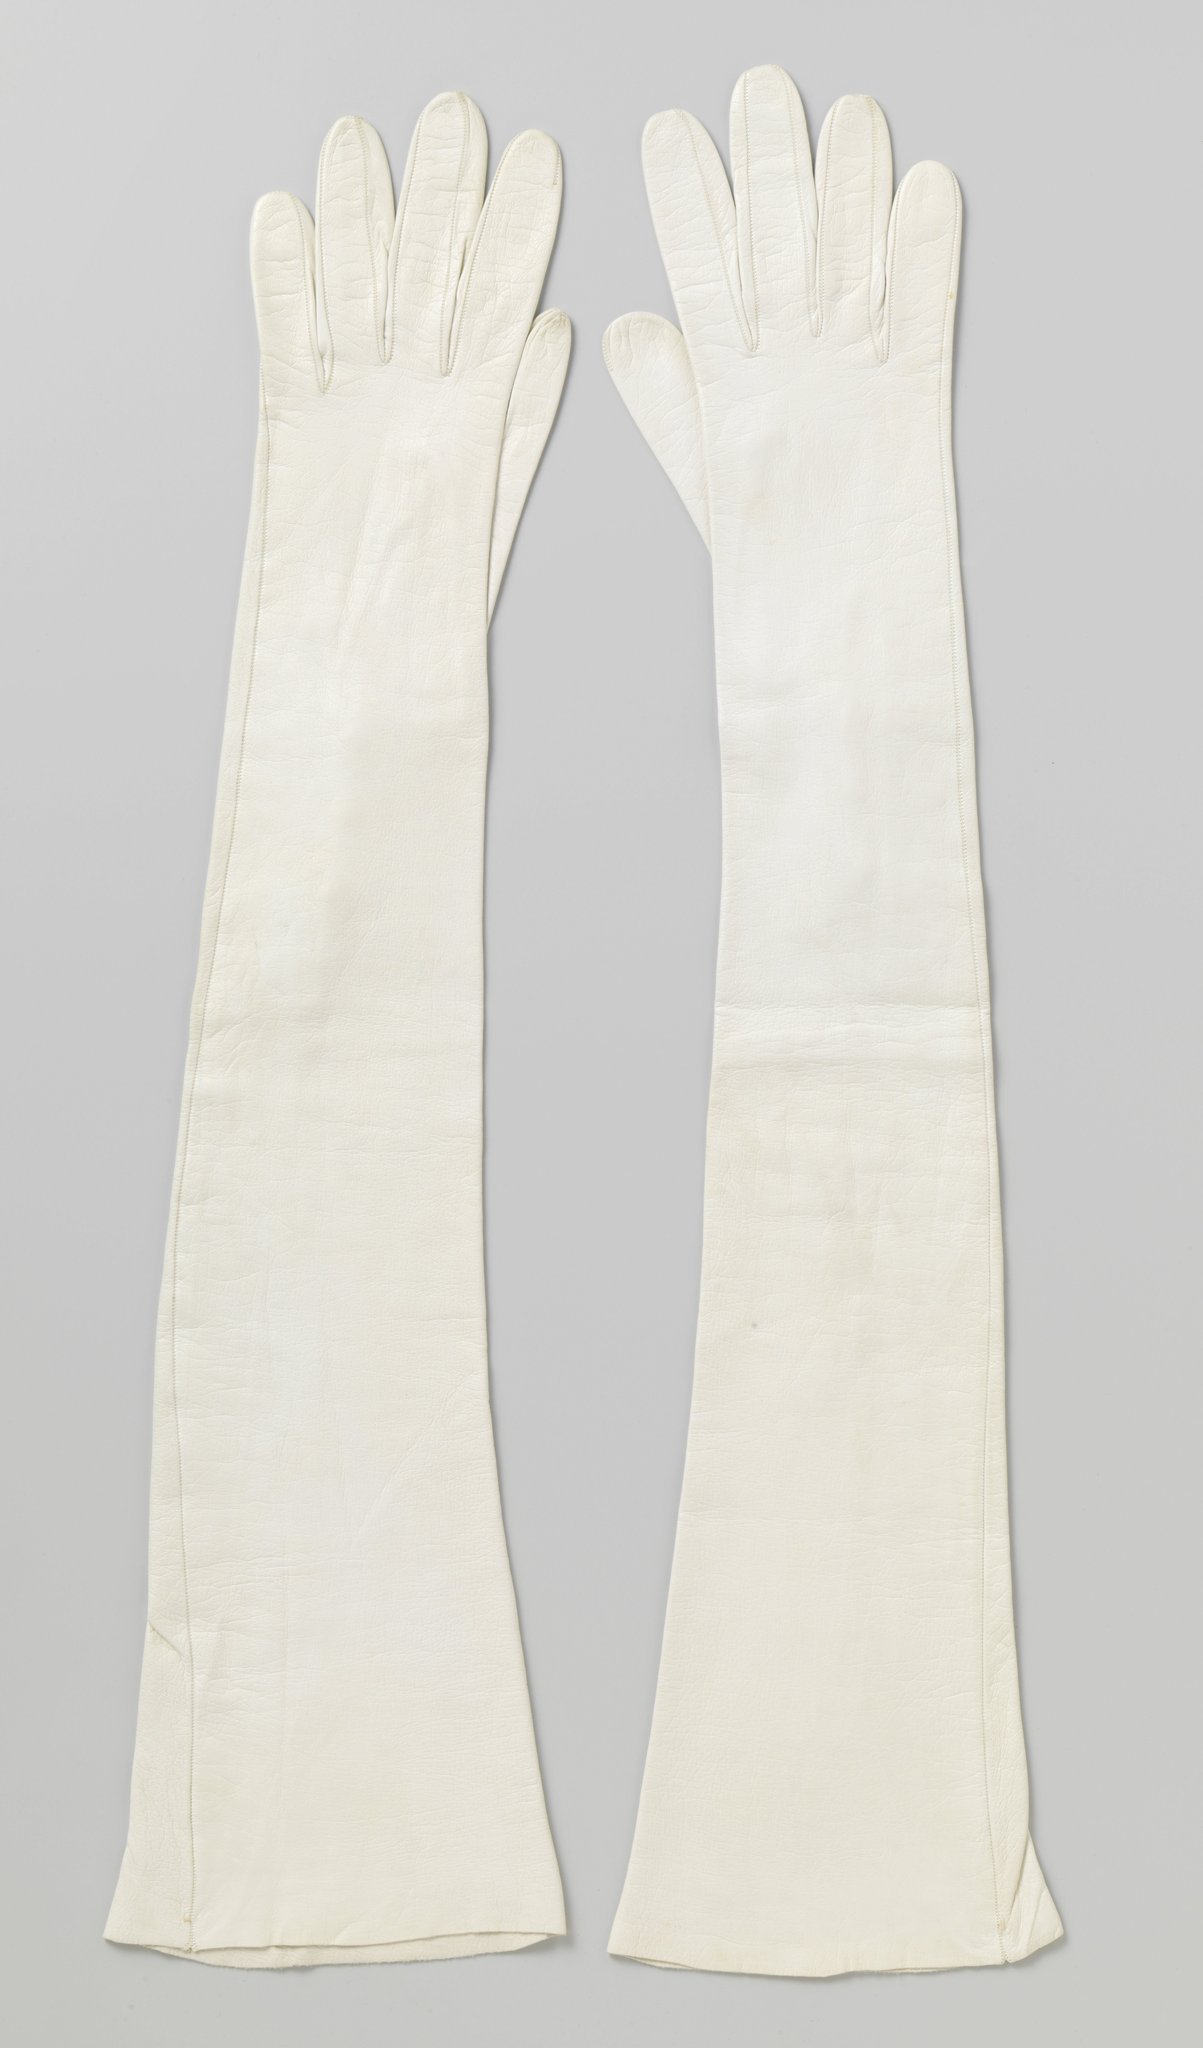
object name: clothing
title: Handschoenen van wit glacéleer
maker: Anonymous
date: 1900-1915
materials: plastic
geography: france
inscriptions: stamp: ‘tekst’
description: Linker handschoenen van wit glacéleer. Bij de pols een split met drie parelmoerkleurige knopen.